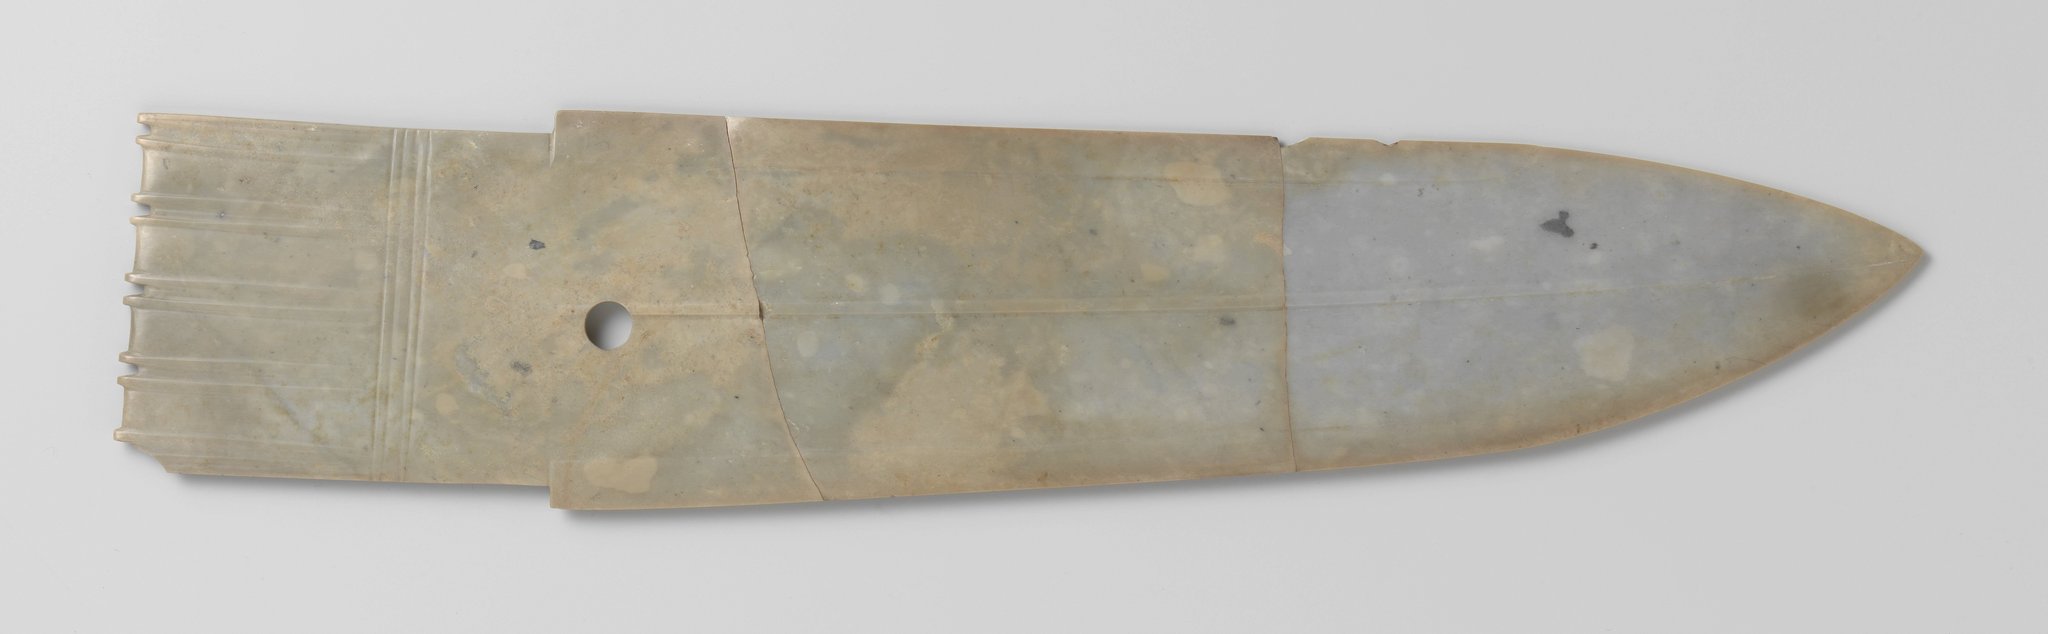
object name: religious ritual object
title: Dagger-axe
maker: Anonymous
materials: jade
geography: china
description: This jade imitation of a bronze dagger-axe was too fragile for use in combat, suggesting that such weapons may have been intended to serve as symbols of military might and status. It is also possible that they were designed for ceremonial use. They were often included in grave goods and may have been specially made for this purpose.